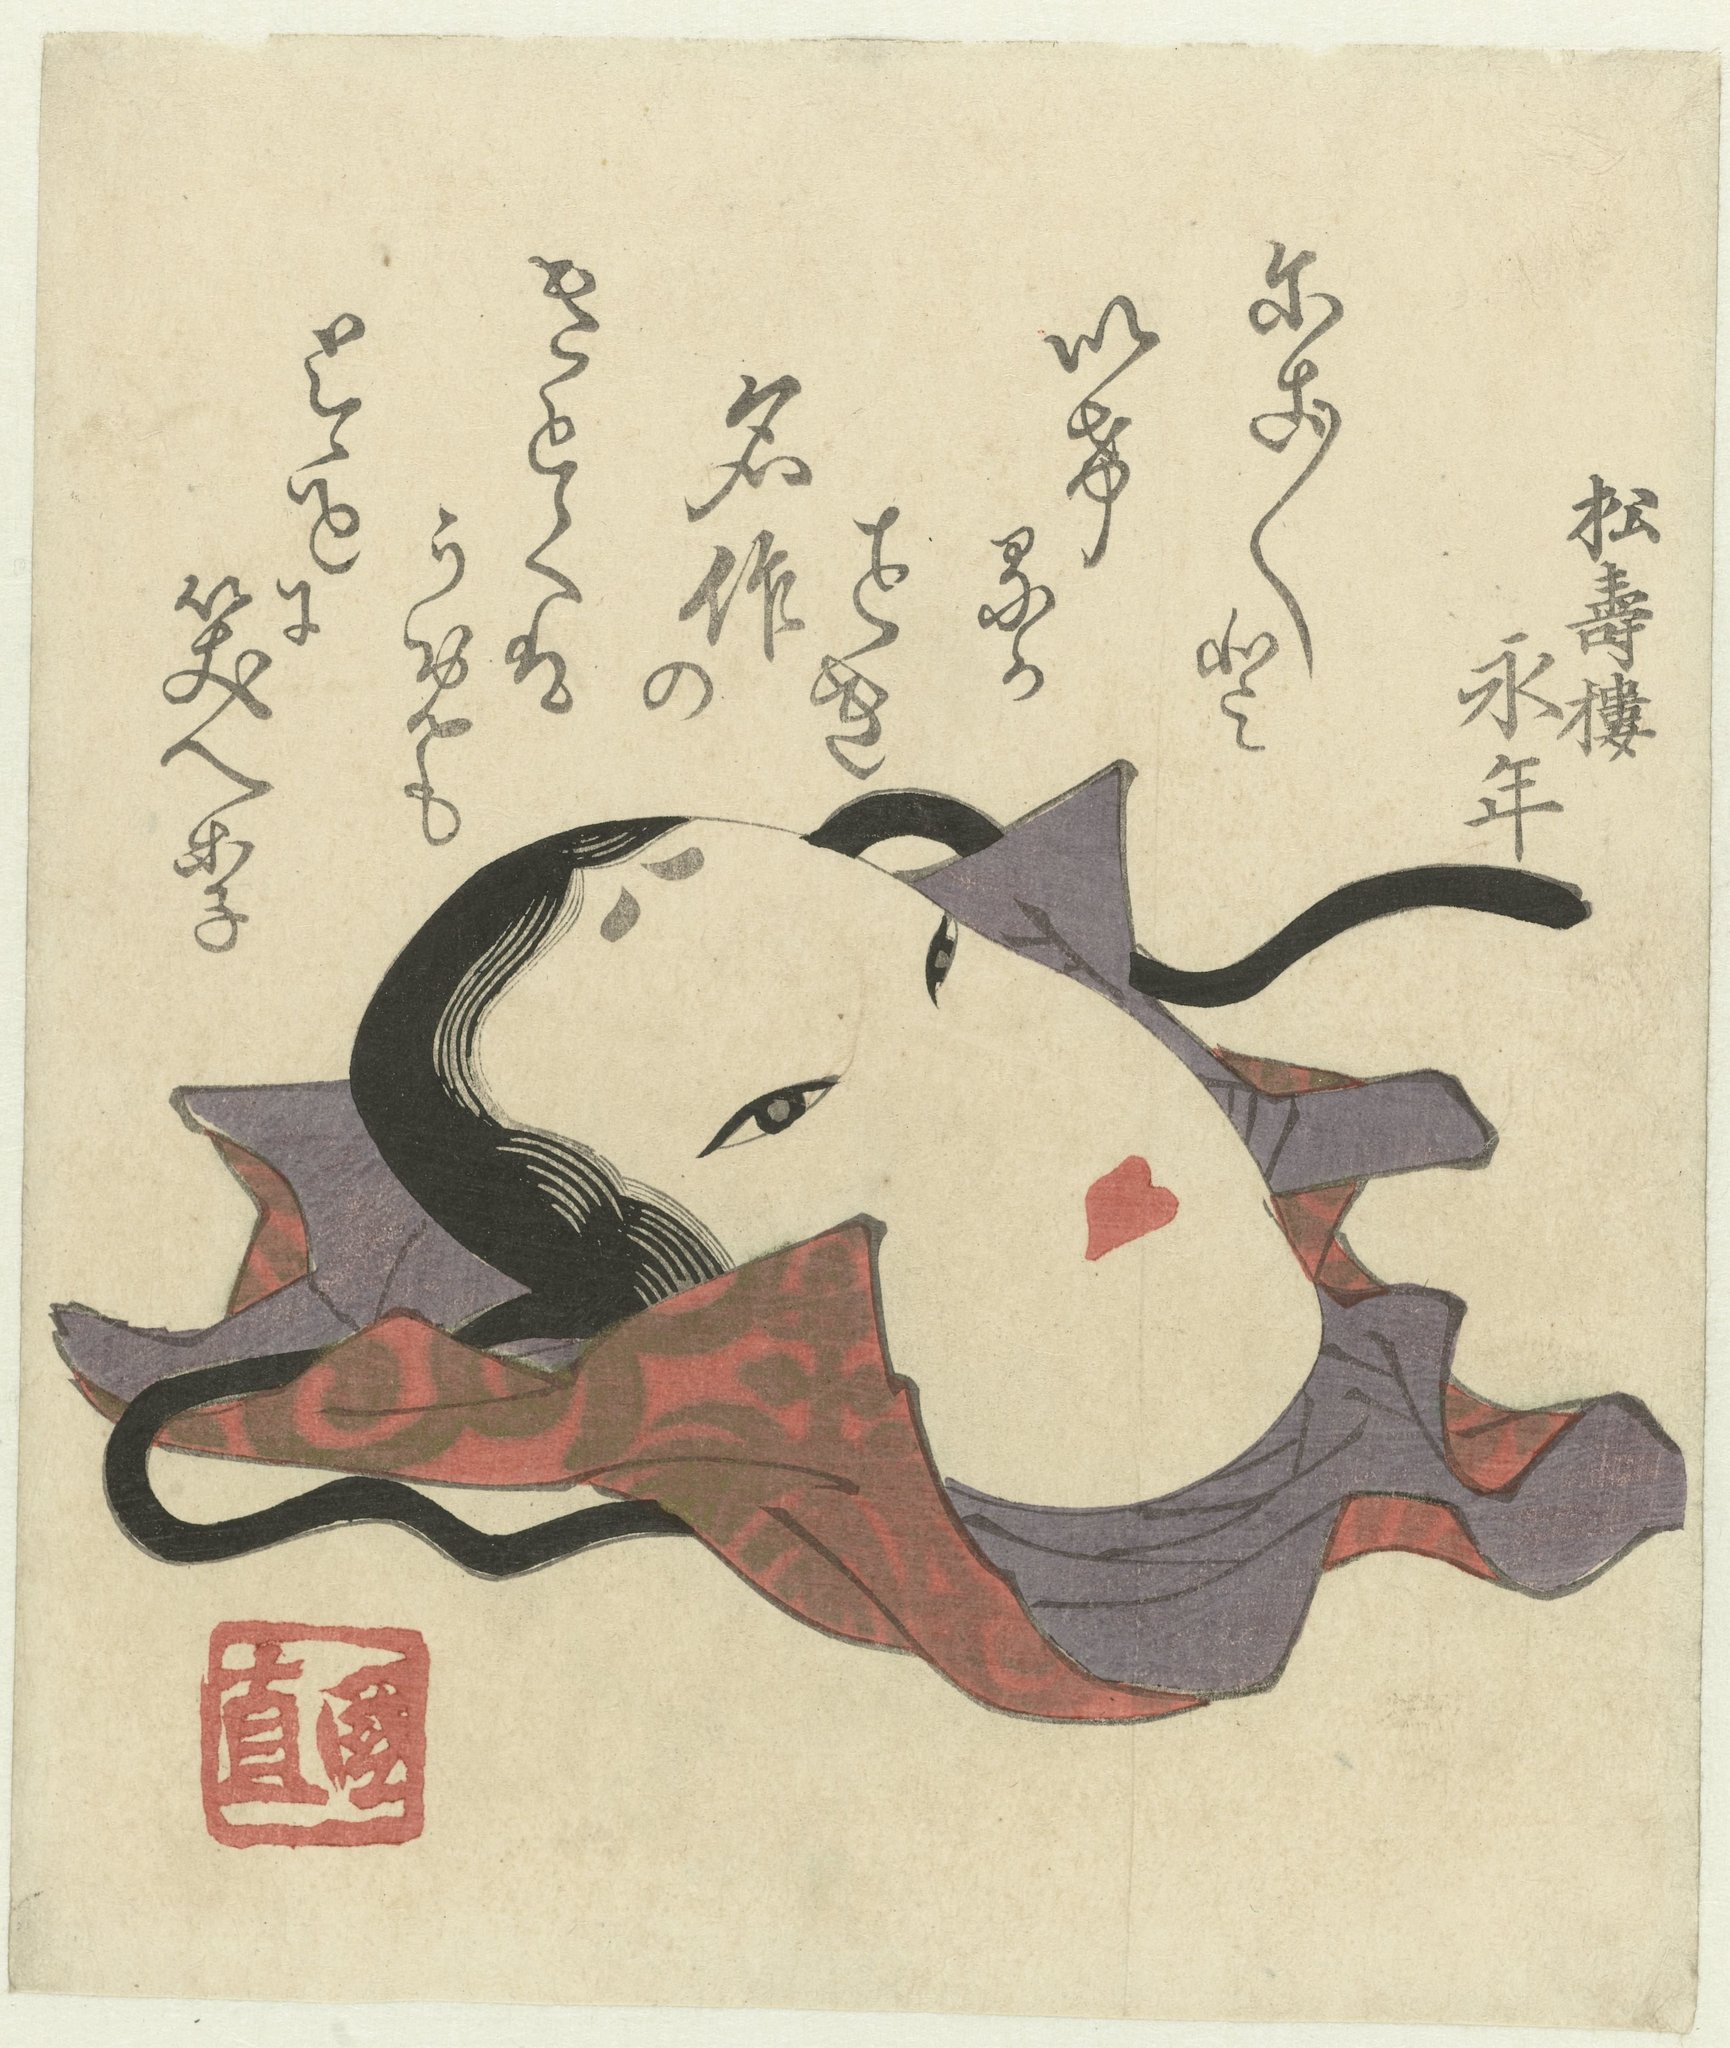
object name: surimono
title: Een Noh masker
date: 1890-1900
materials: paper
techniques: blind stamped, woodcut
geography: japan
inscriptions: collector's mark, collector's mark: Lugt 2228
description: Een surimono is een luxe uitgevoerde prent waarop beeld met één of meerdere gedichten gecombineerd is. Bij het drukken van een surimono werd vaak gebruik gemaakt van dikker papier, blinddruk en metaal pigmenten, zoals koper- en zilverpoeder. De prenten werden vaak in opdracht van dichters gemaakt en als exclusief geschenk aan vrienden en relaties gegeven.